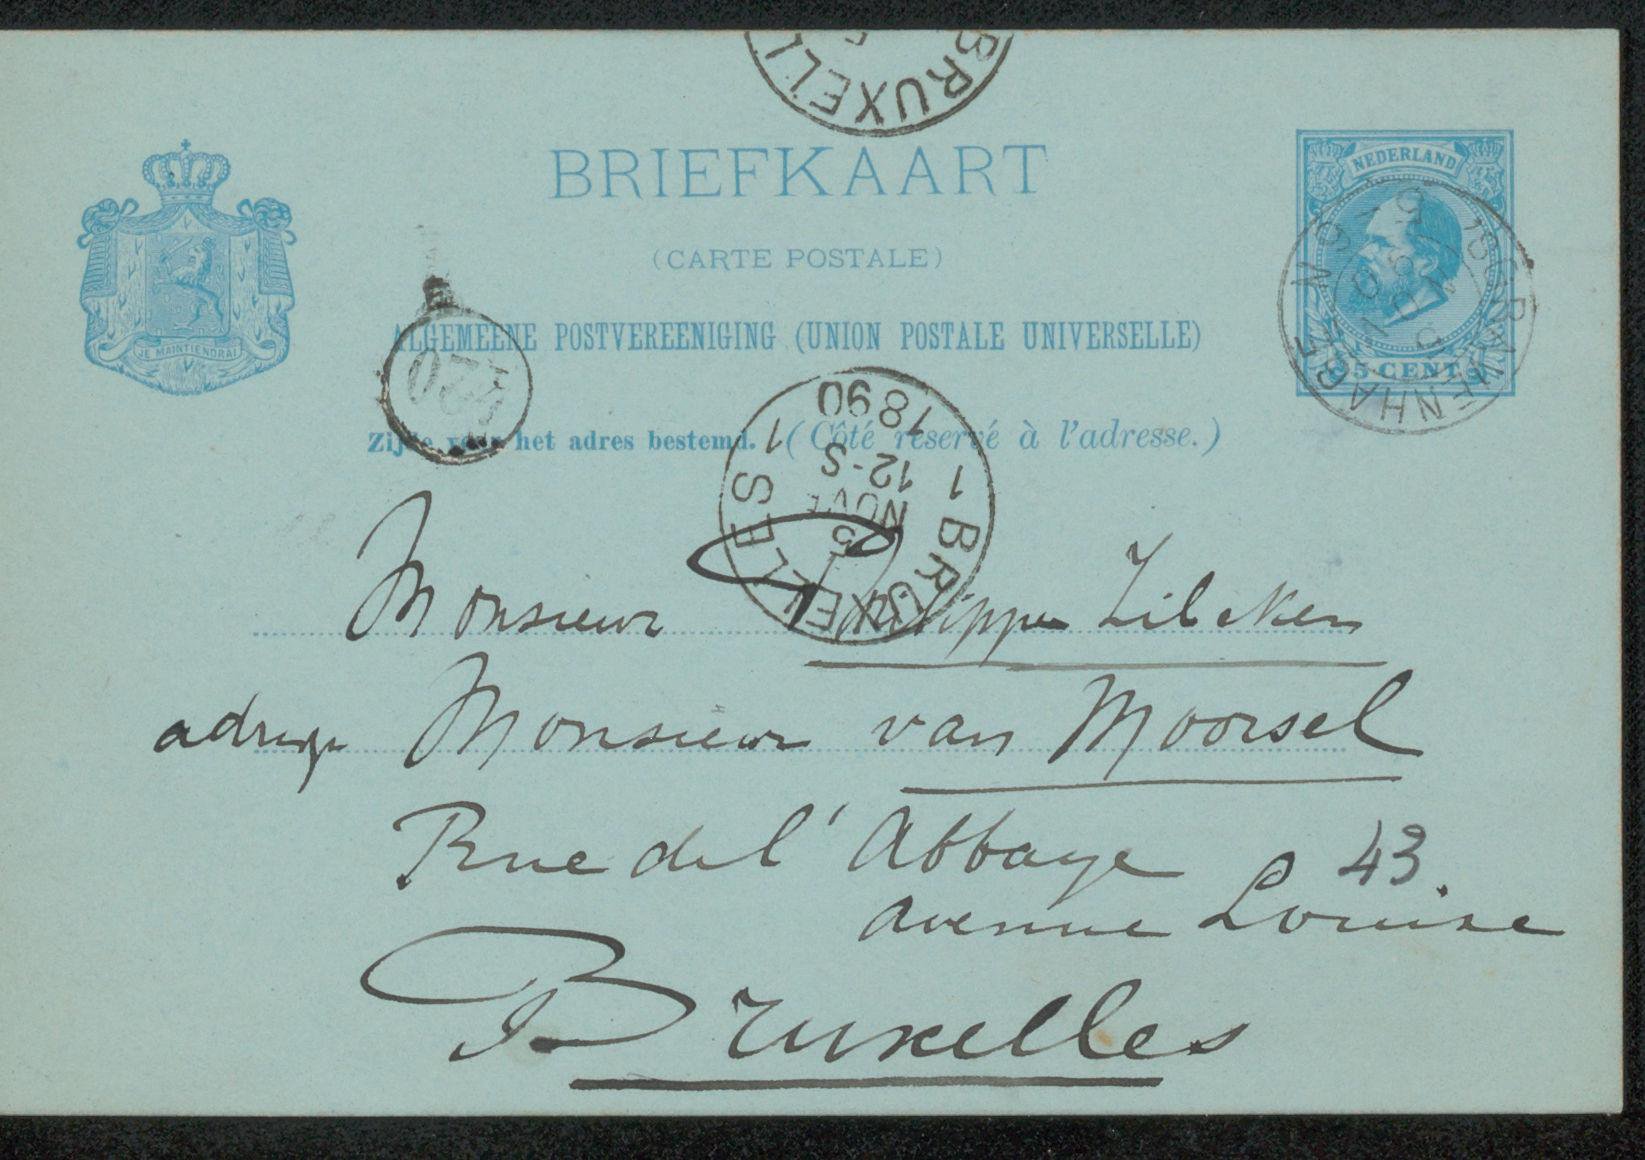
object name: postcard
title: Briefkaart aan Philip Zilcken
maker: marinus van der maarel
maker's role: draughtsman, painter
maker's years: 1857-1921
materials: cardboard, ink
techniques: pen, writing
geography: the hague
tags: dordrecht, amsterdam, painter, print maker, draughtsman, designer, jan veth, publisher, philip zilcken, the graphic arts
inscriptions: collector's mark: ‘RPK’